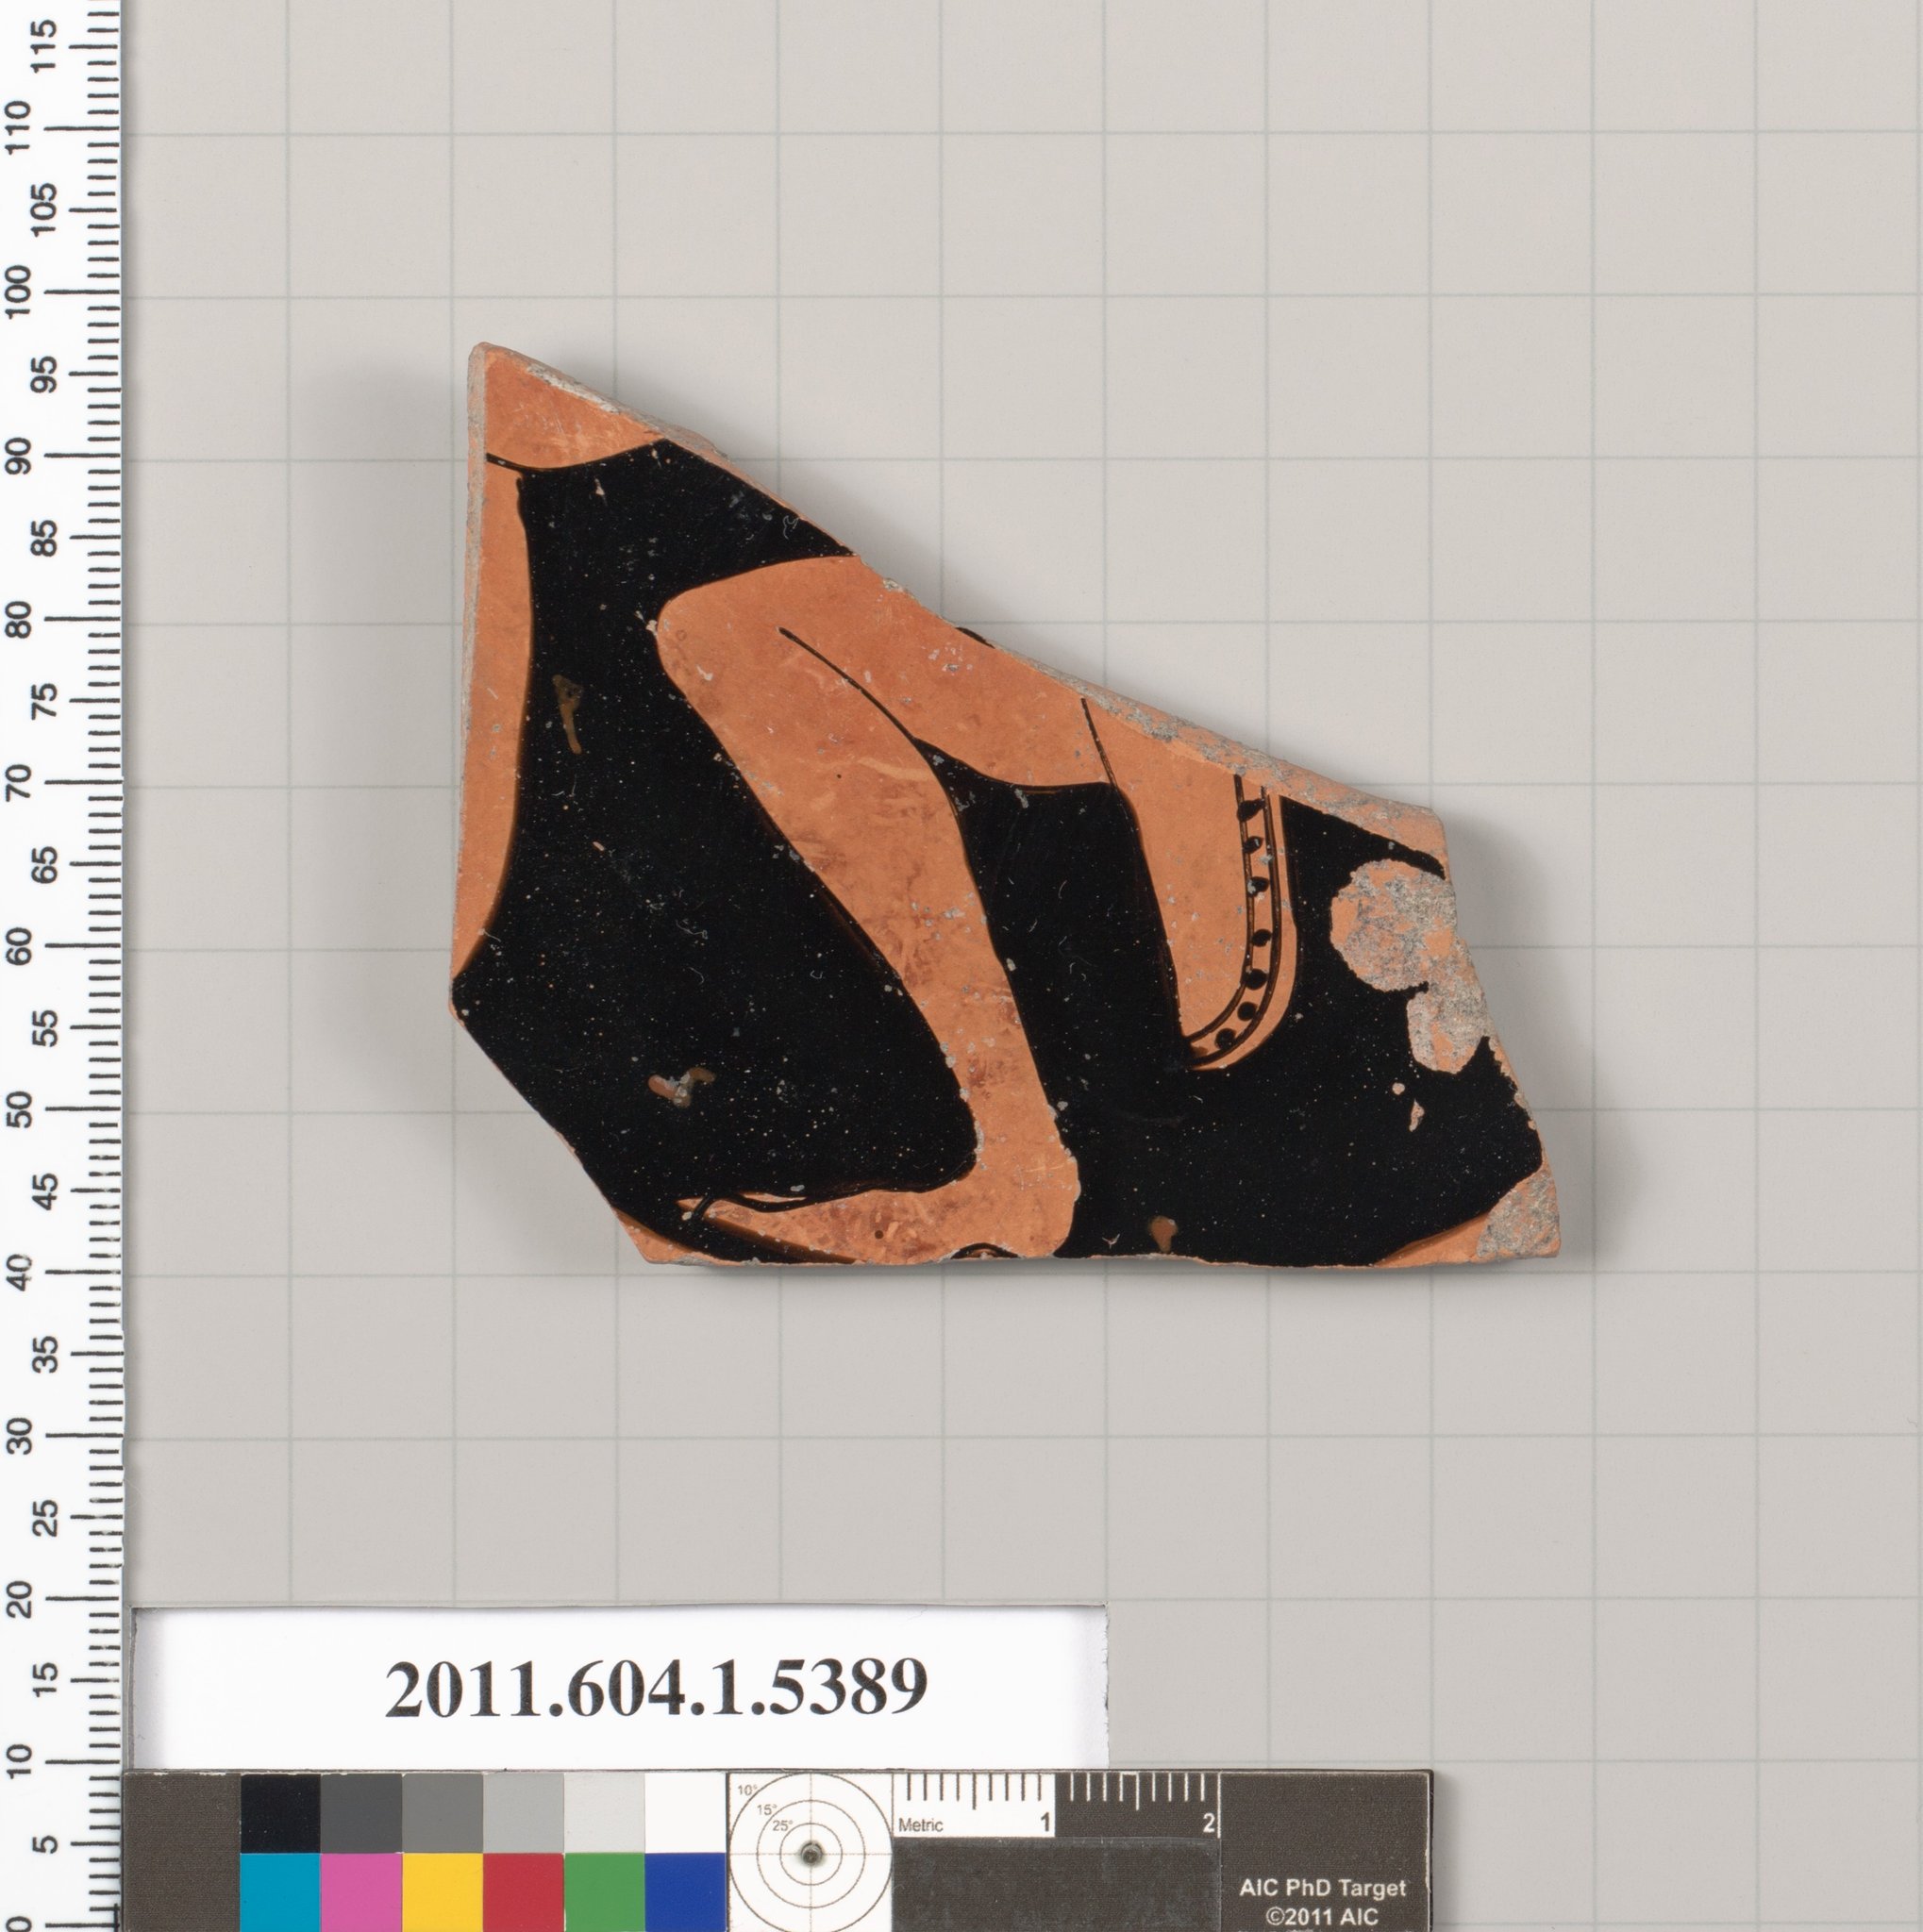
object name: kylix fragment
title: Terracotta fragment of a kylix (drinking cup)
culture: greek, attic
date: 520-500 BCE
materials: terracotta